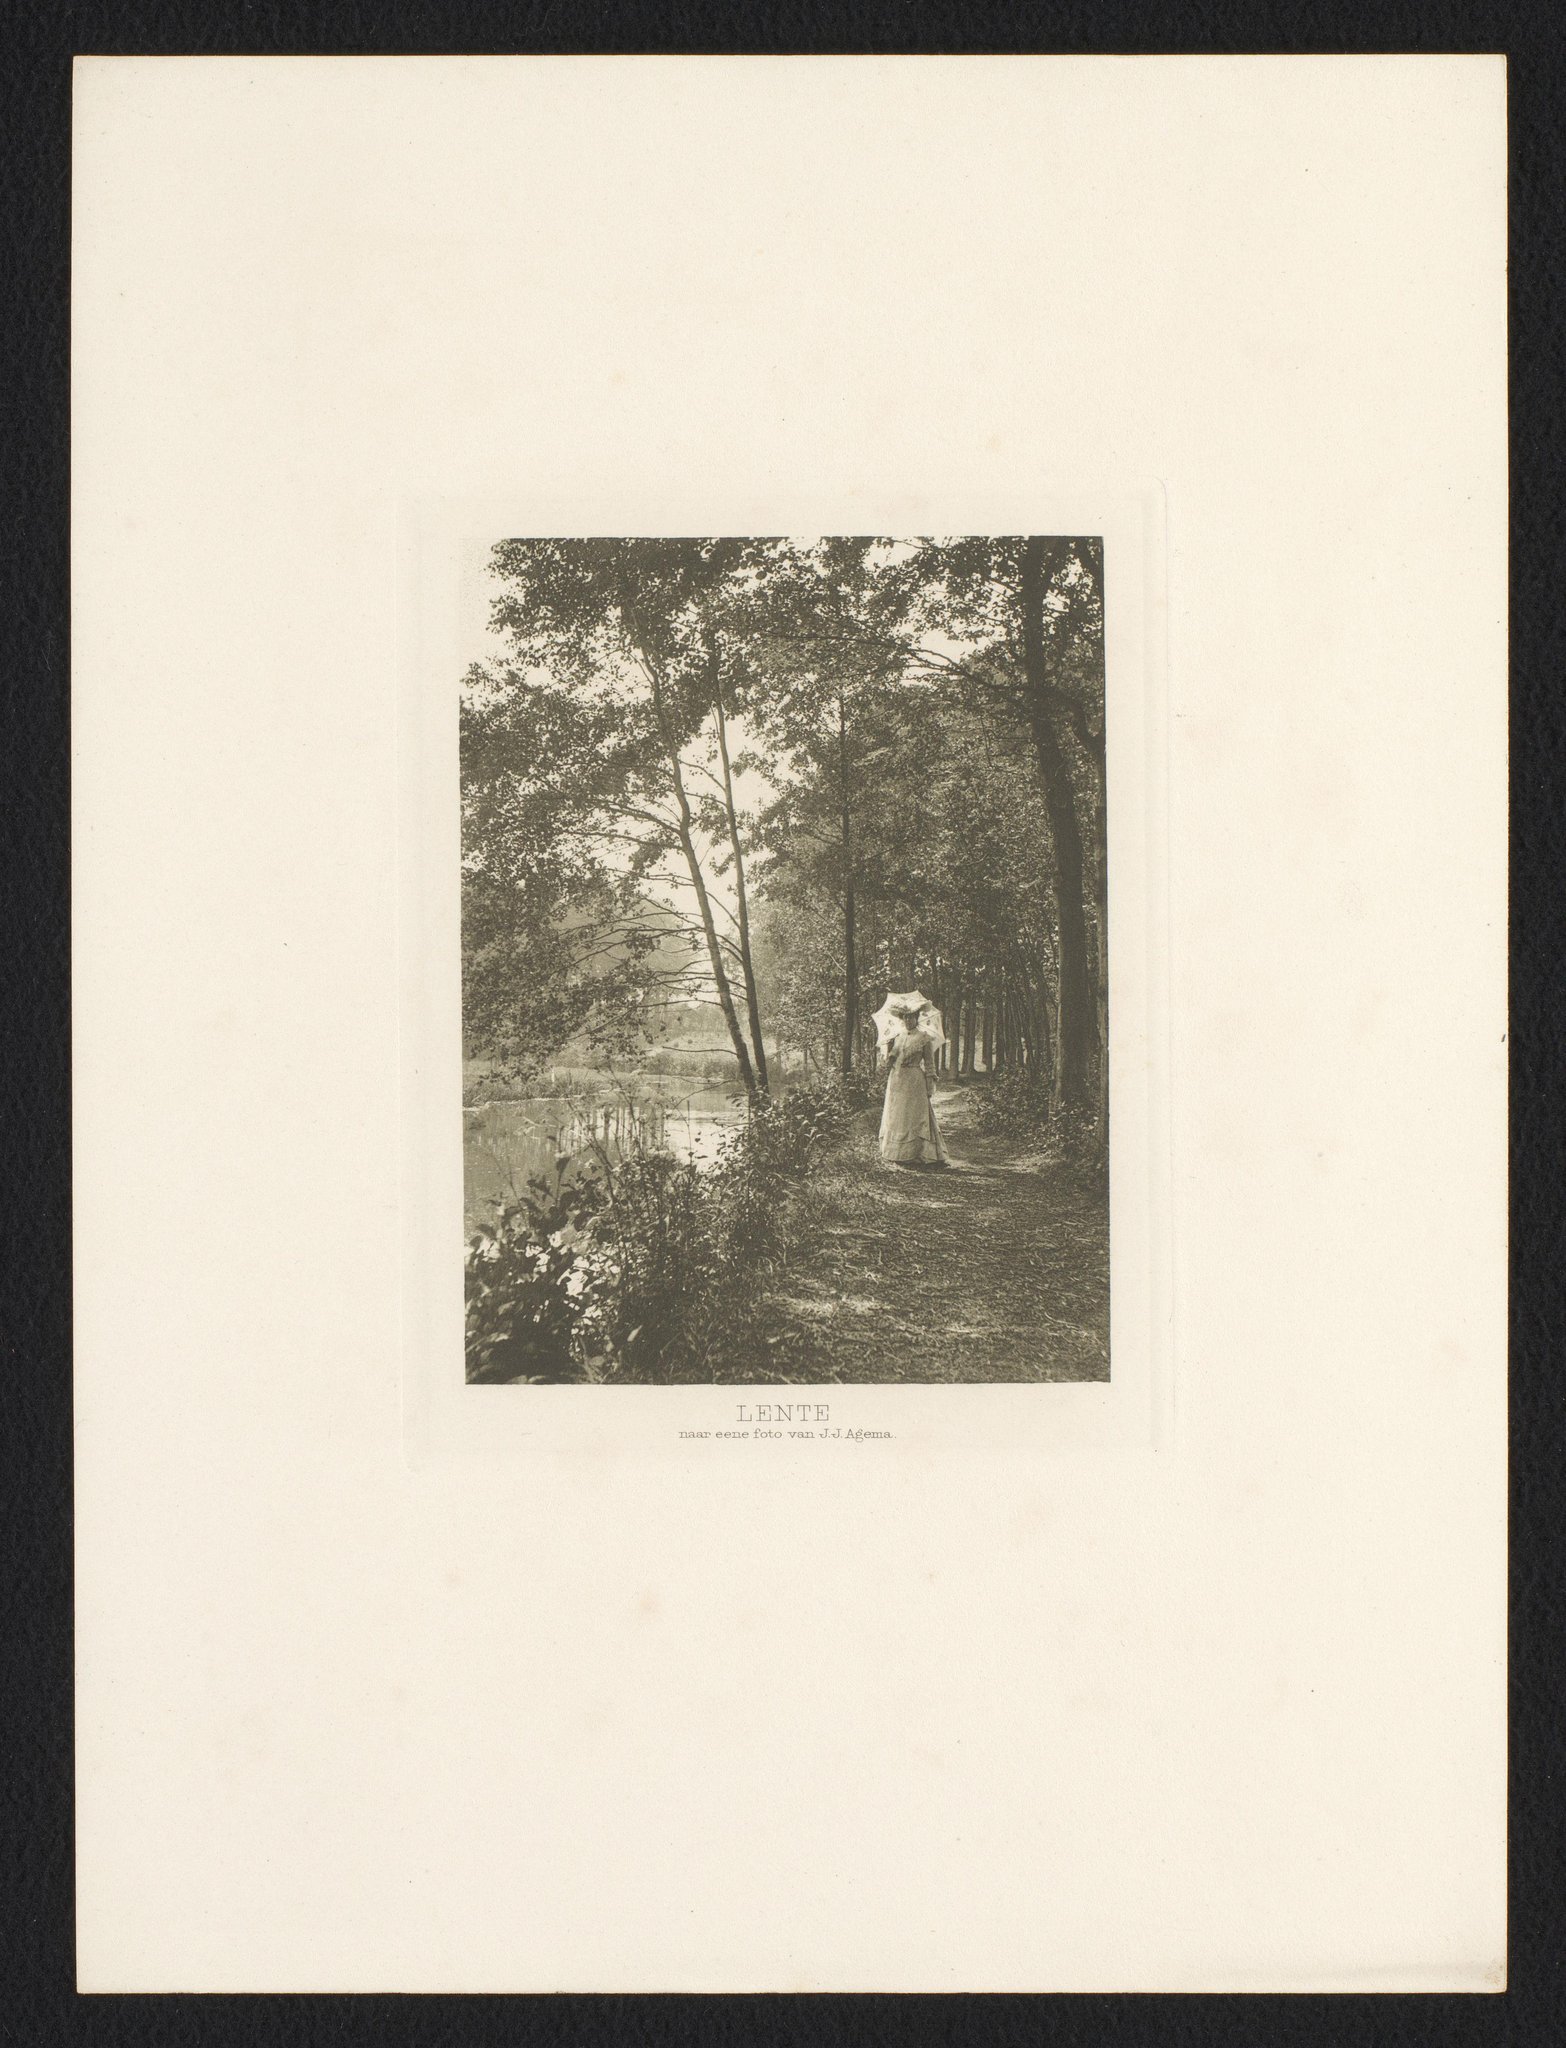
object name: page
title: Vrouw in het bos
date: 1899-1904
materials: paper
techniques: photoaquatint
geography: netherlands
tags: adult woman, forest, wood